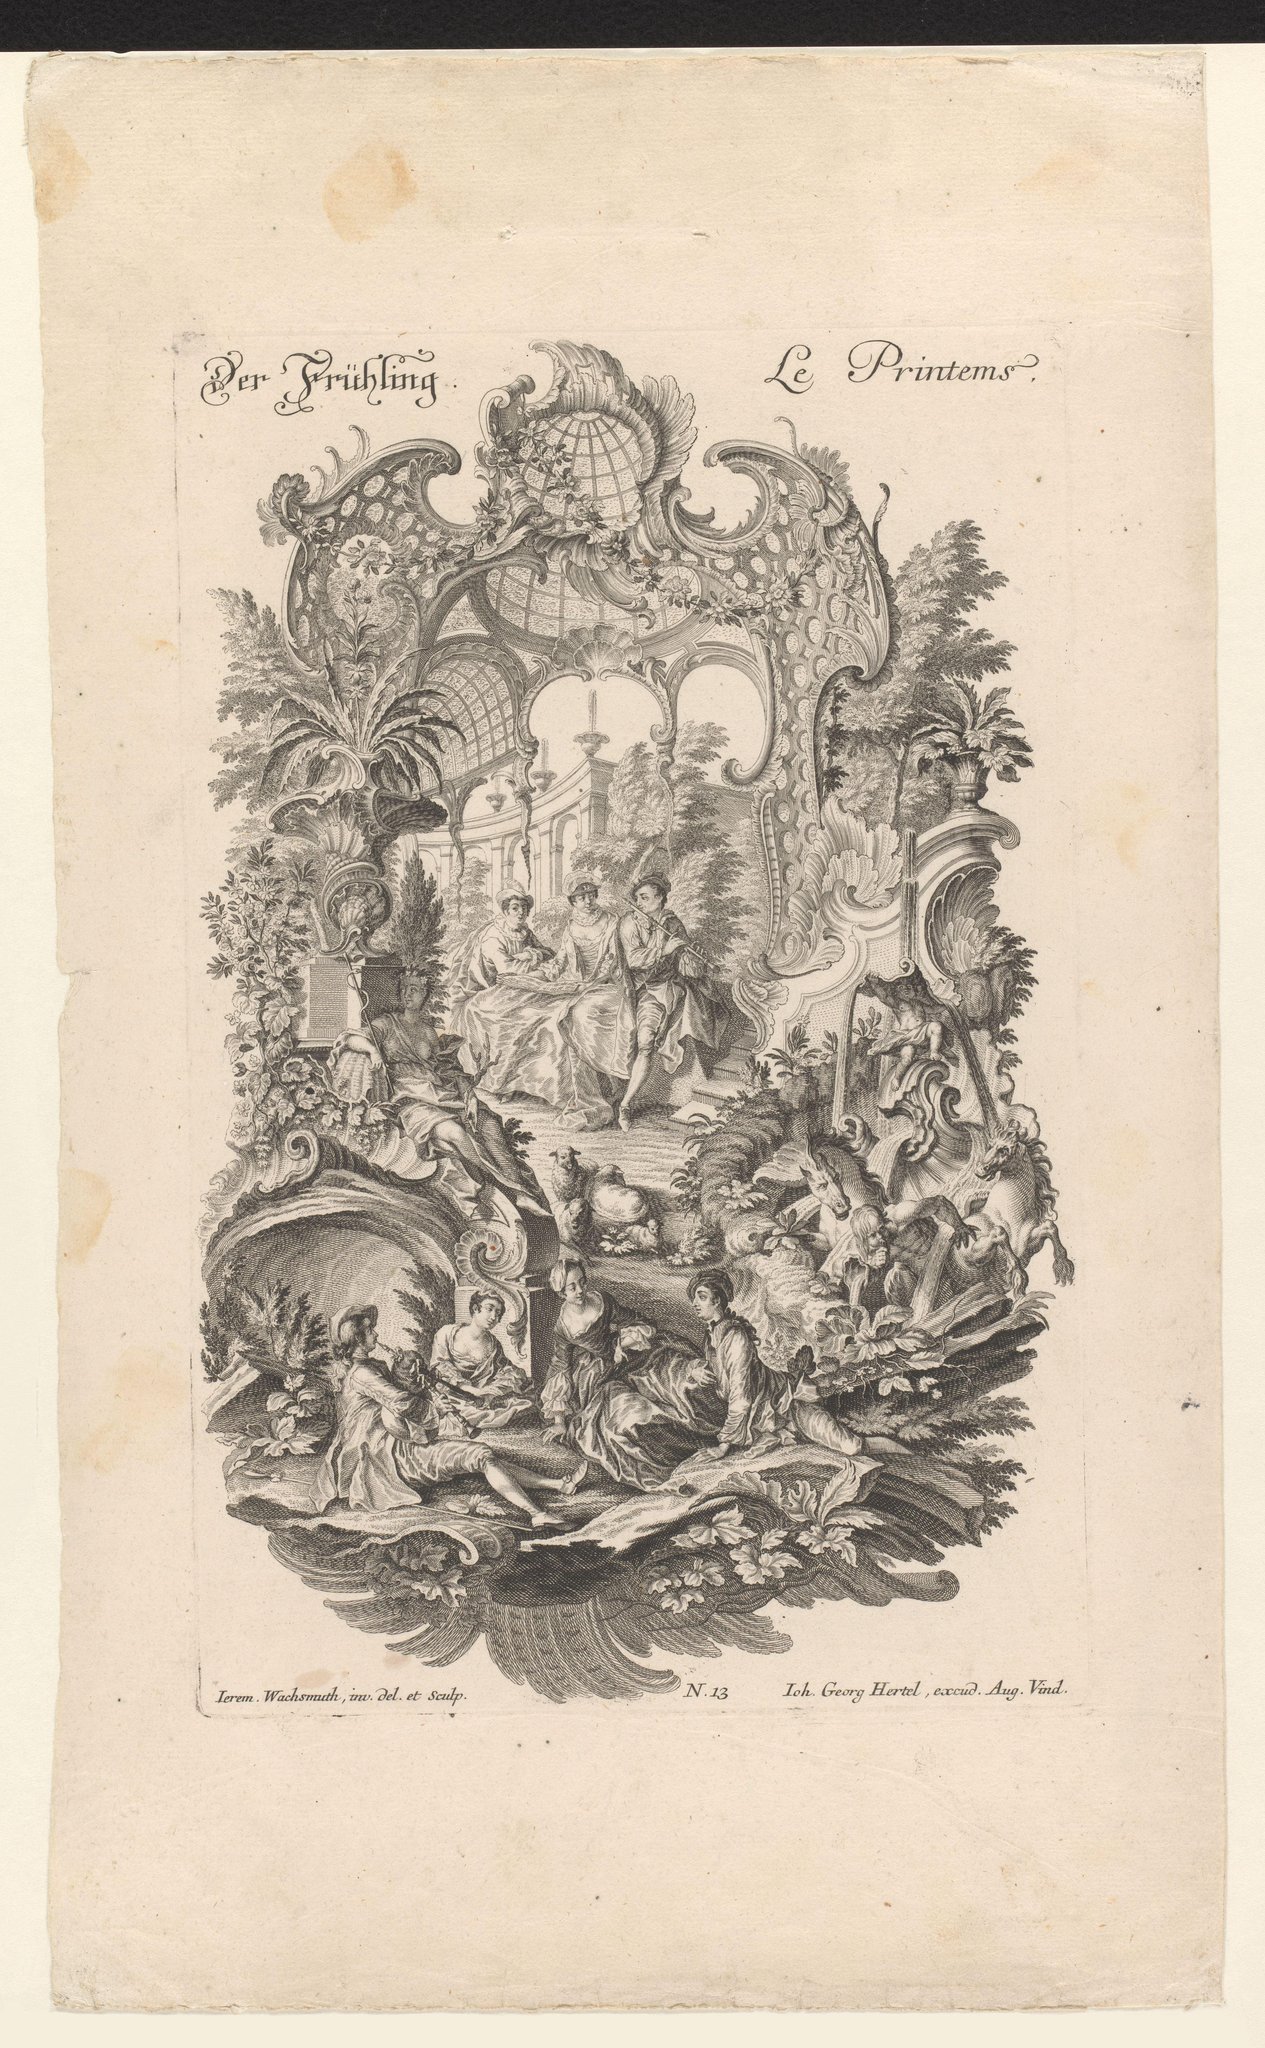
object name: print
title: Lente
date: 1721-1771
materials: paper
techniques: etching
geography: augsburg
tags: reading, making music; musician with instrument, spring, 'ver'; 'primavera' (ripa), garden fountain, aesculapian sign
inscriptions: collector's mark: Lugt 2228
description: Drie figuren zitten in een tuin, zij lezen en maken muziek. Rondom een rocaille omlijsting. Links zit een vrouw met bloemenkrans en een esculaap. Rechts een fontein met putti en paarden. Op de voorgrond zitten vier figuren, de man links speelt op een doedelzak. Uitgeversnummer 13.